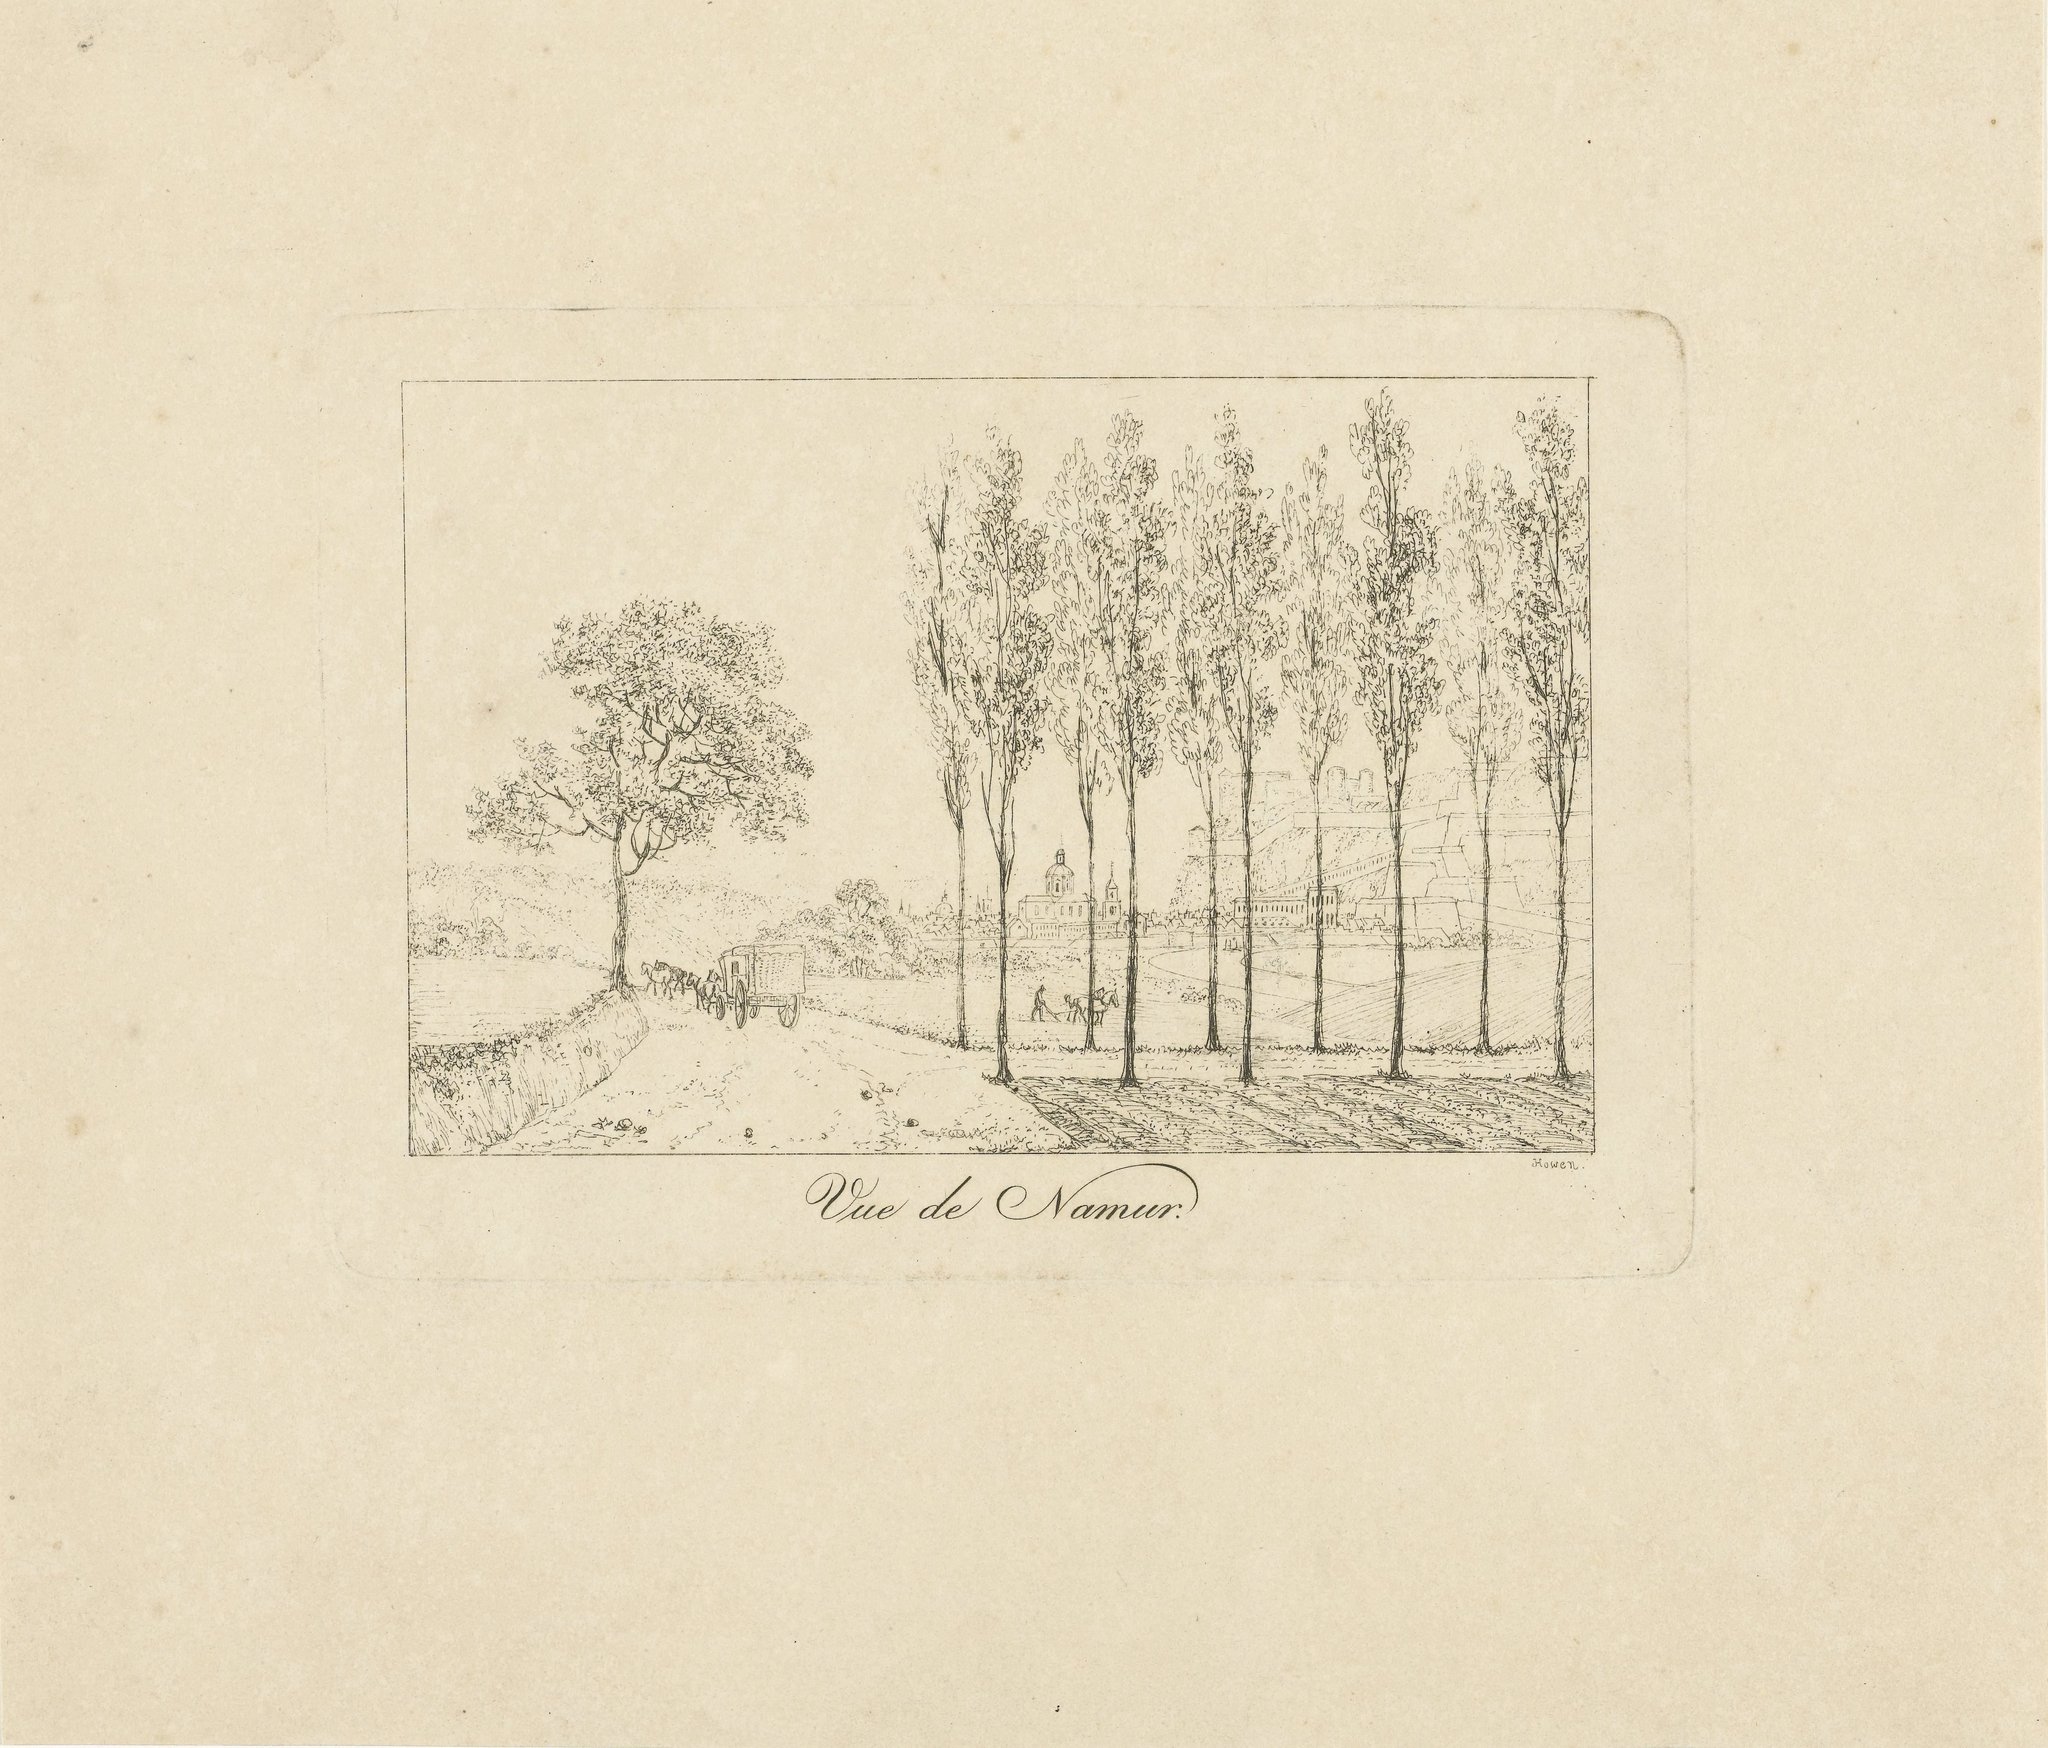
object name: print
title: Vue de Namur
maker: otto baron howen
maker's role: draughtsman, print maker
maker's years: 1774-1848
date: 1784-1848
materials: paper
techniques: etching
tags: landscapes (+ landscape with figures, staffage)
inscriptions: collector's mark: Lugt 2228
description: Een landschap met bomen en links een weg met paardenkoets. Rechts achter de bomen de stad Namen.